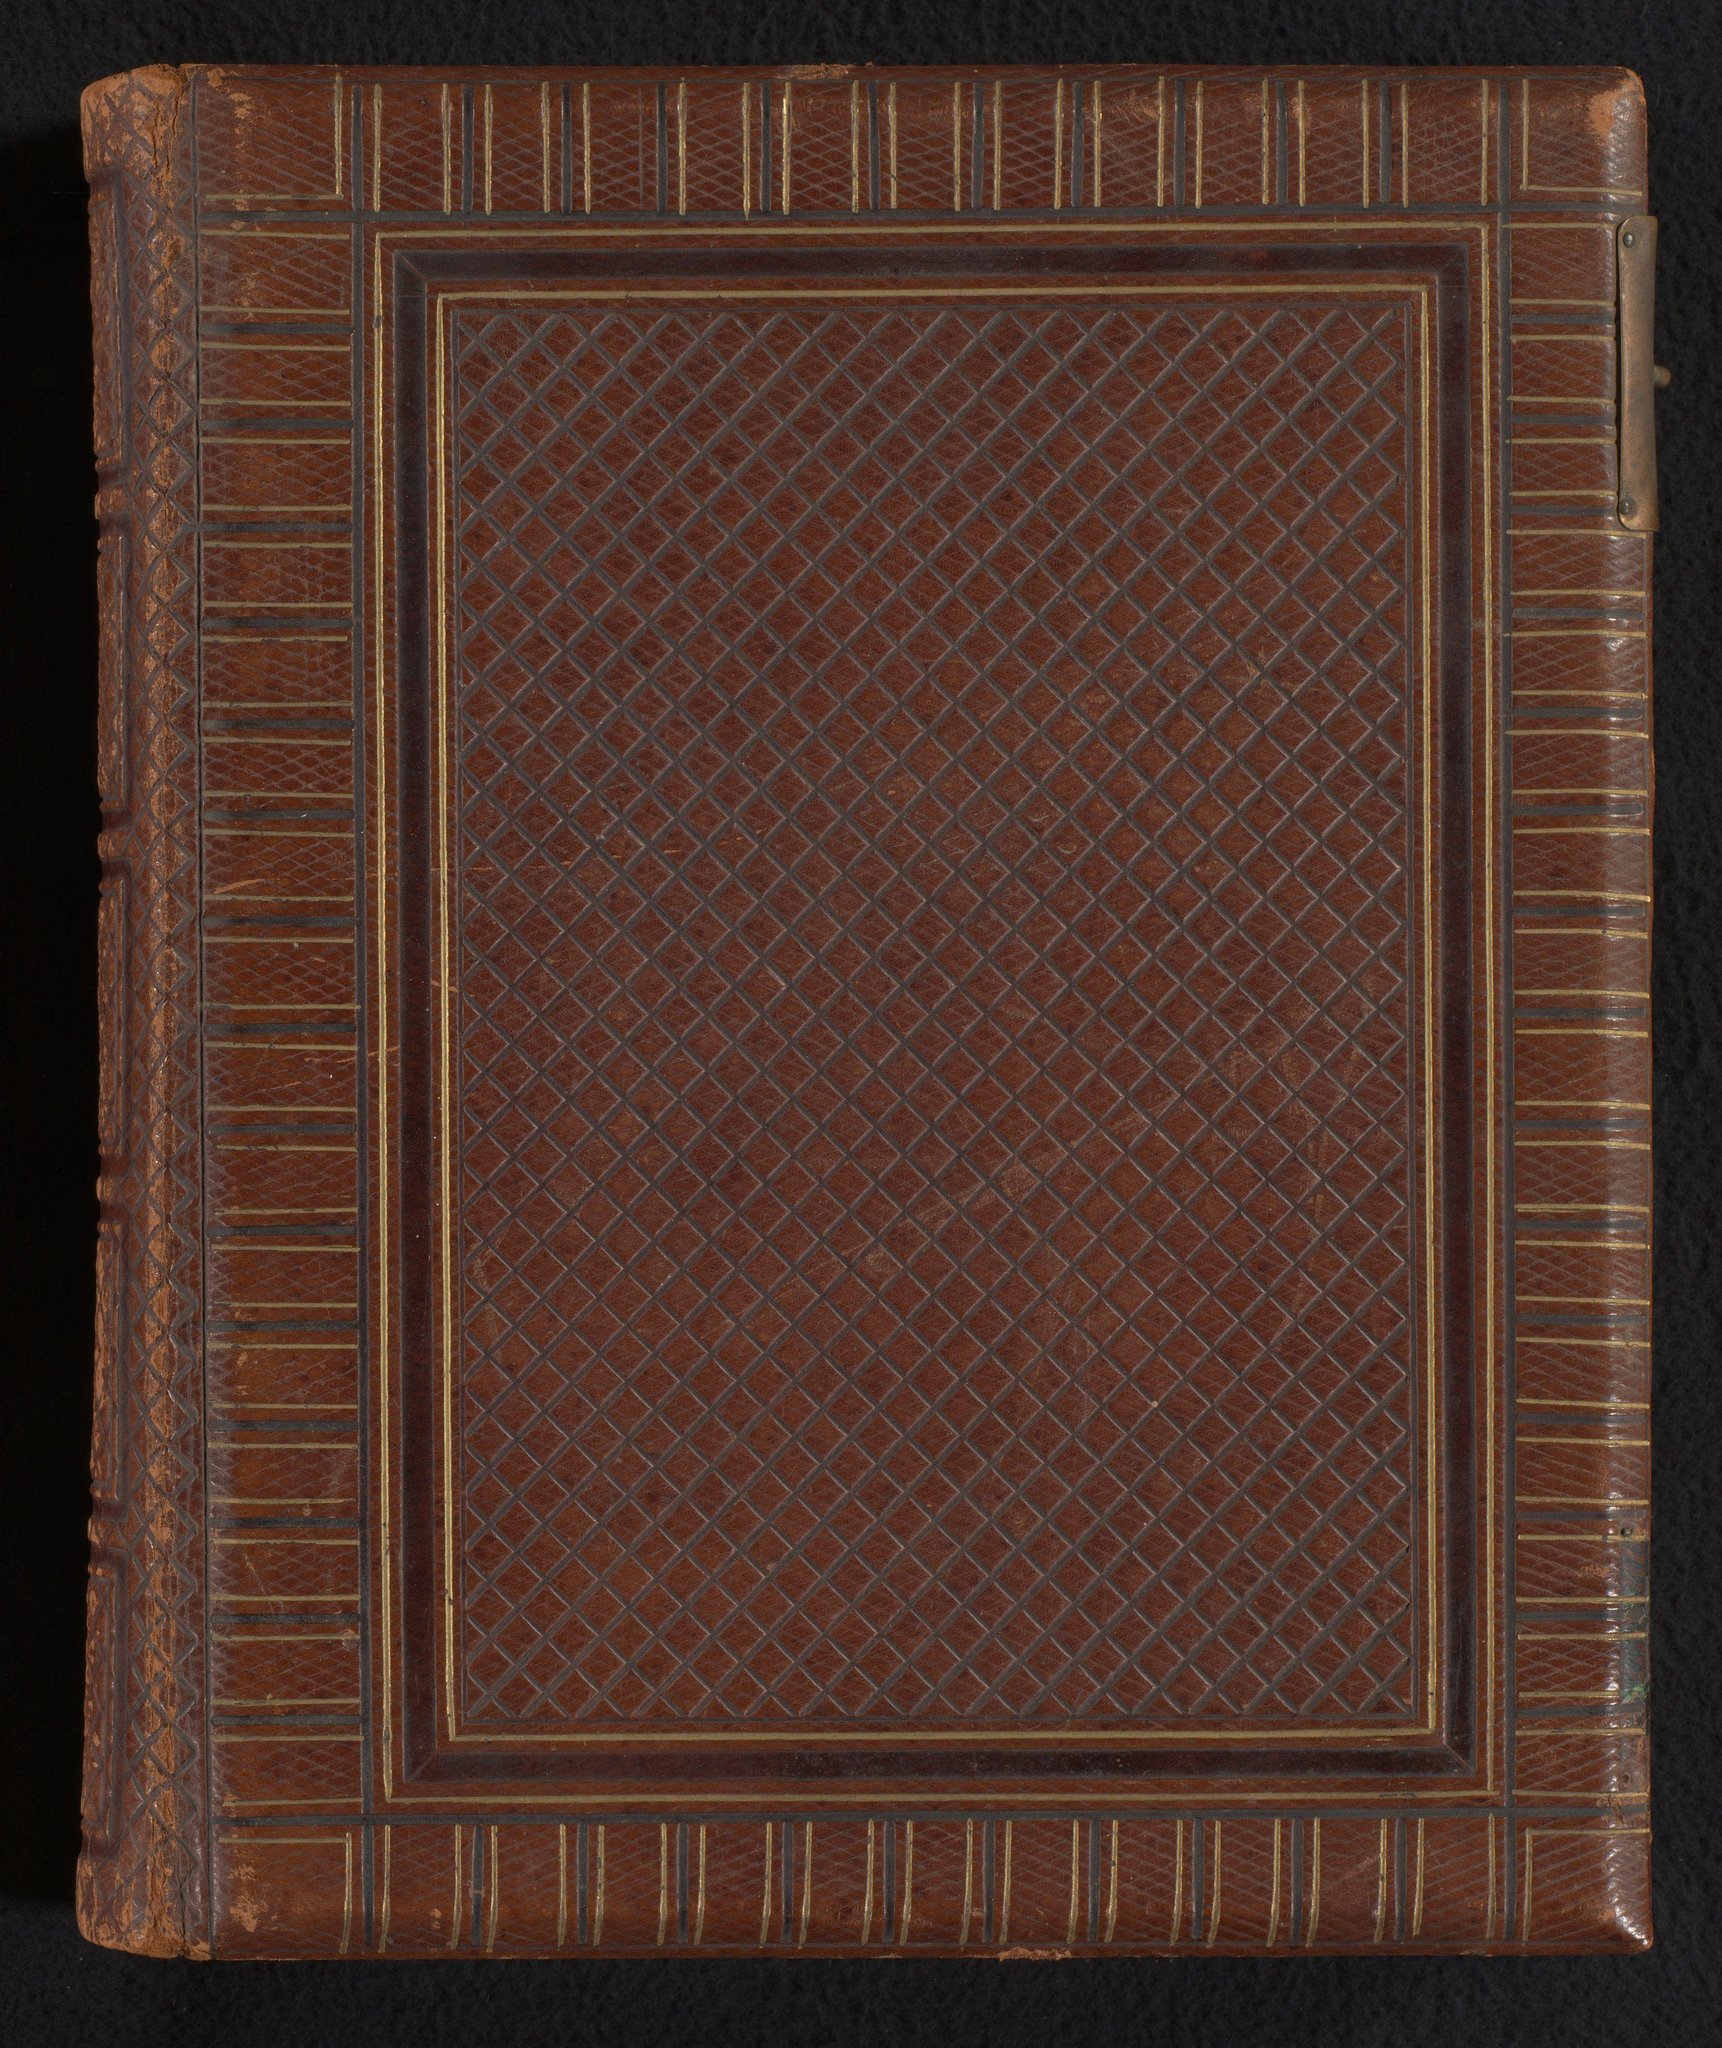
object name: photograph album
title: Insteekalbum met 109 cartes-de-visite van de familie Kessler-de Lange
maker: Anonymous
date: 1870-1890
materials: paper, cardboard, leather, textile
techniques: albumen print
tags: margaretha jacoba johanna kessler-de lange (margo), jean baptiste august kessler (1853-1900), historical persons, anonymous historical person portrayed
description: Insteekalbum met 109 cartes-de-visite op 44 bladen van de familie Kessler-de Lange, waaronder ook een portret van gouverneur-generaal Van Lansberge in burger, en portretten van Margo Kessler als klein kind, de meeste gemaakt in het voormalige Nederlands-Indië. Achterin het album zit een serie cartes met fotografische afbeeldingen van sculpturen en reproducties van schilderijen.